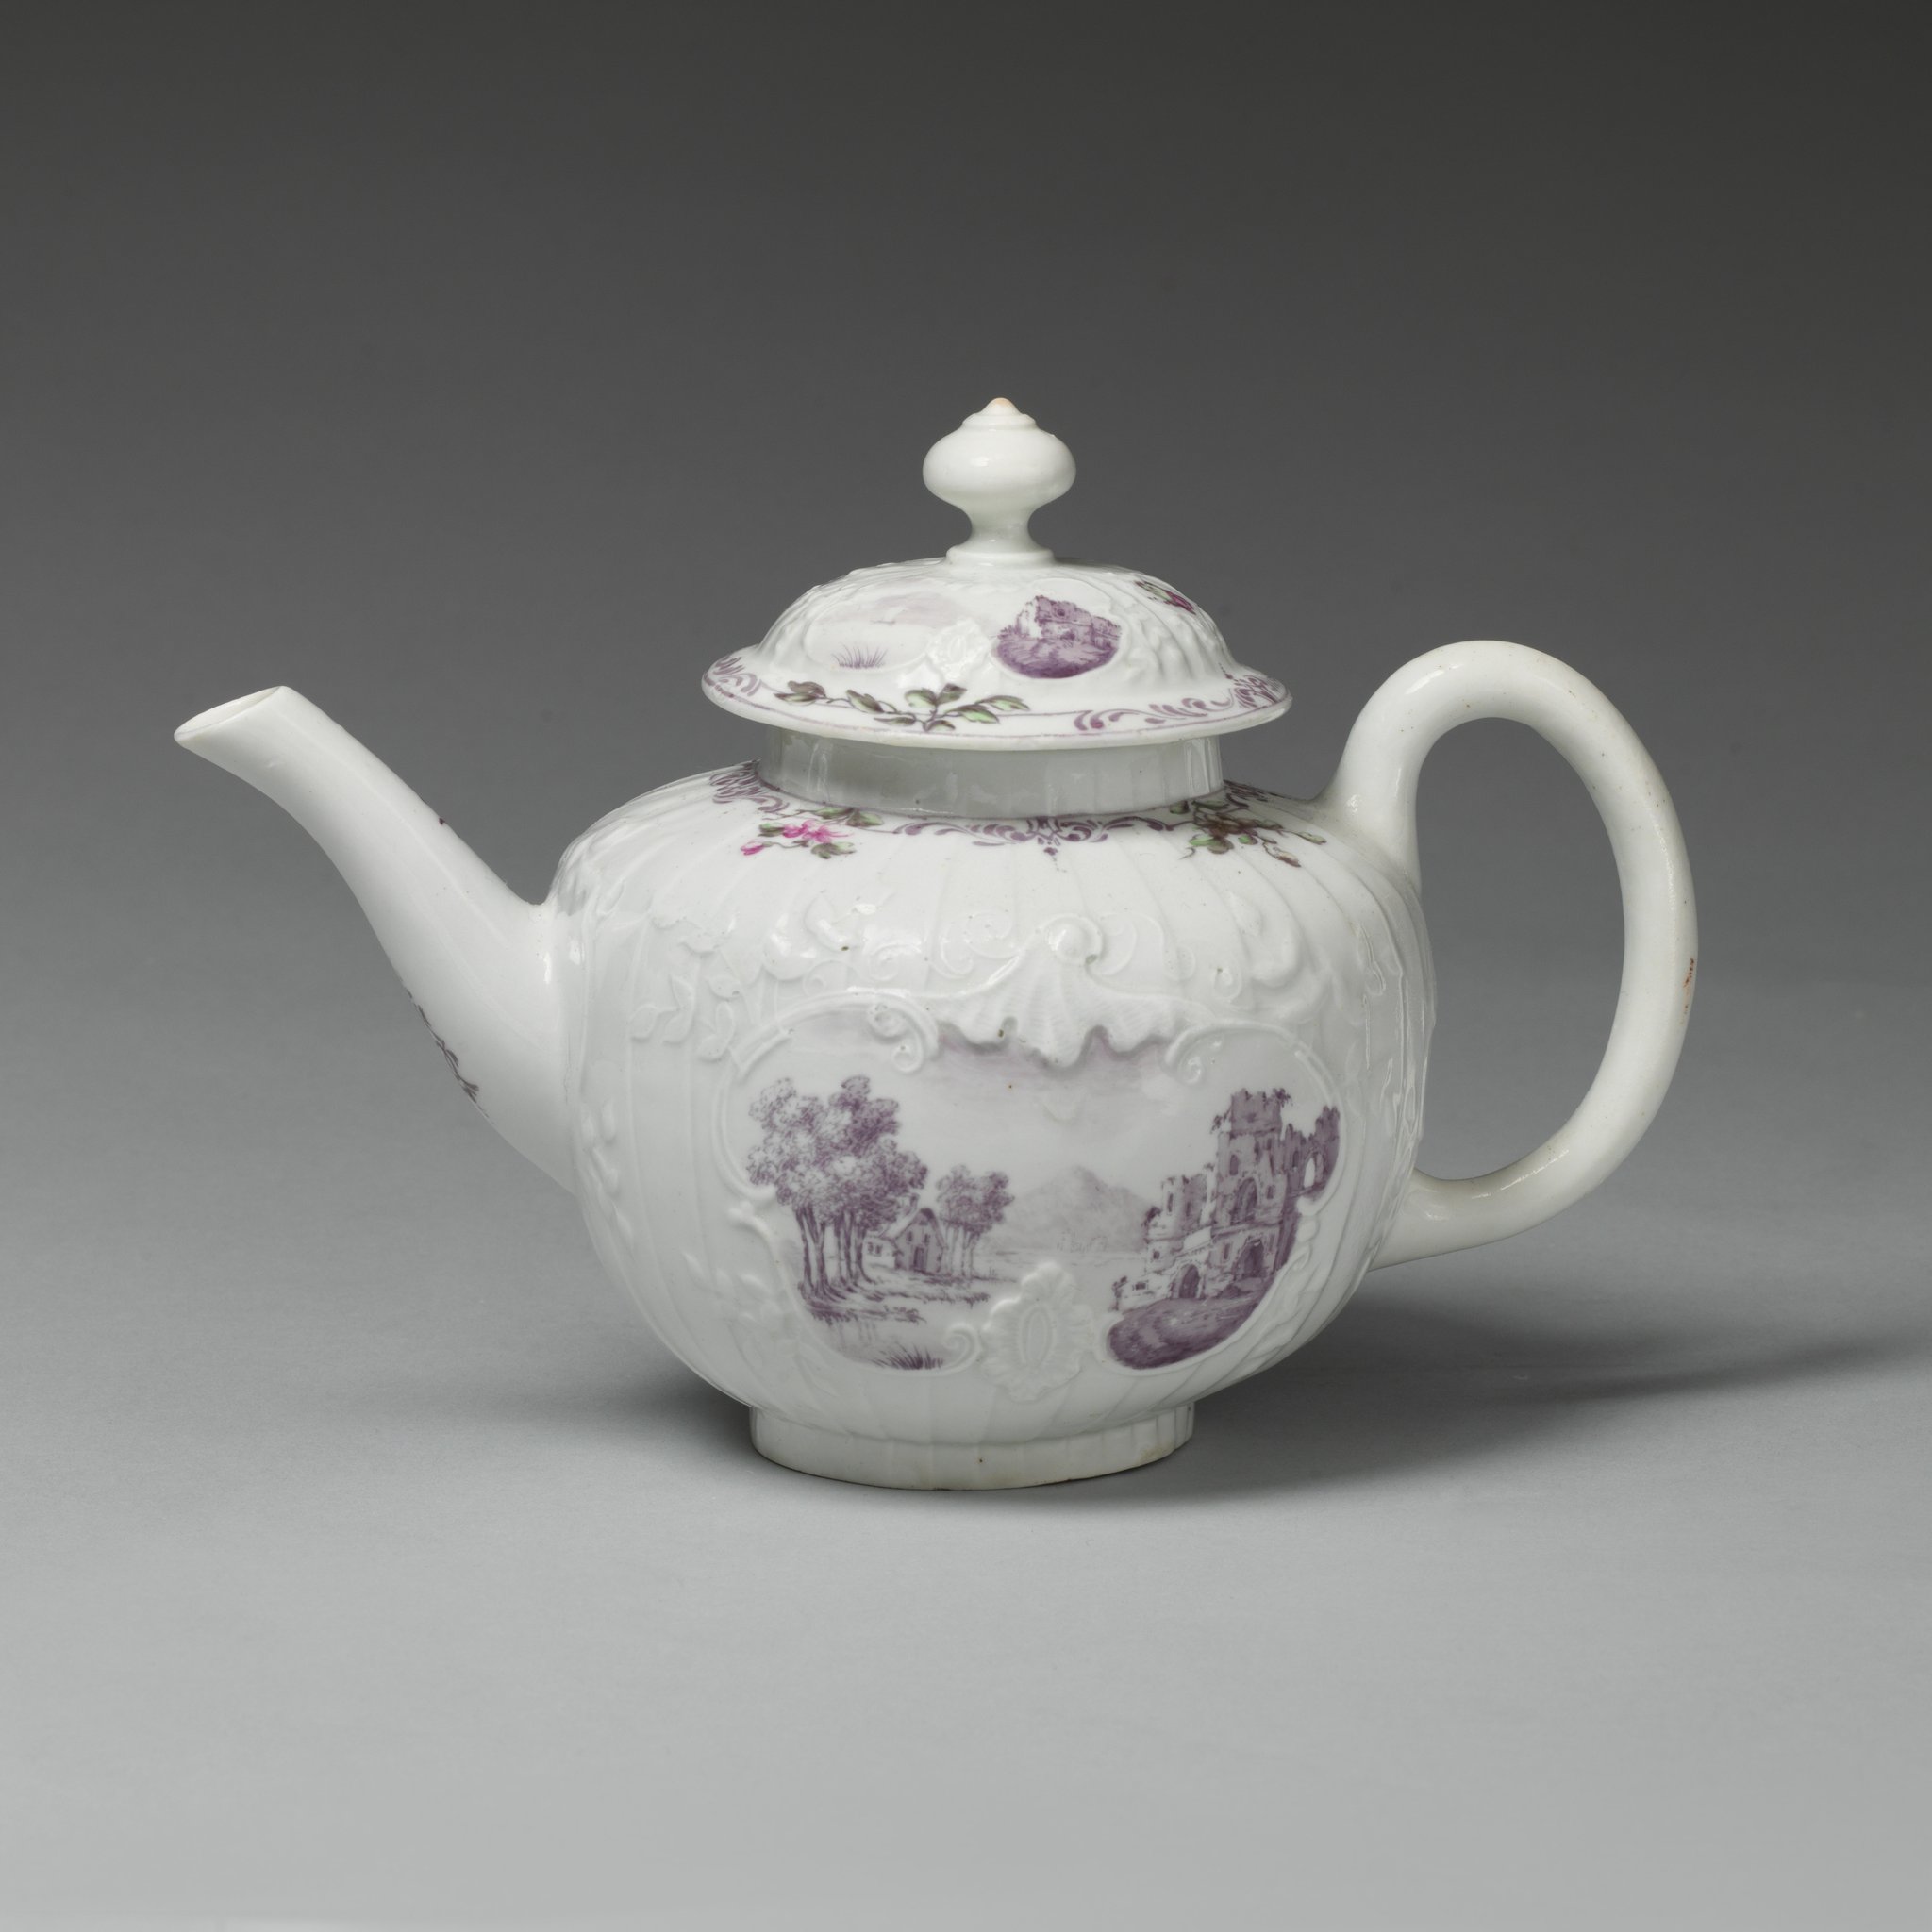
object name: teapot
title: Teapot with ruins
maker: worcester factory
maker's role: factory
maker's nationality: british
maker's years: 1751-2008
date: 1765-1770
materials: enamel, soft paste porcelain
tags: houses,trees